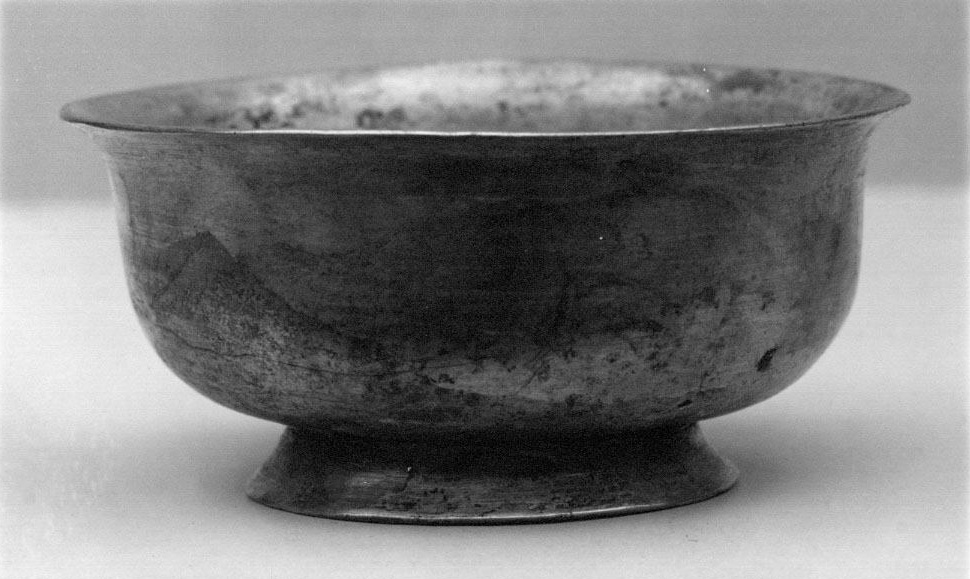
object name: bowl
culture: chinese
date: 618-907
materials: silver